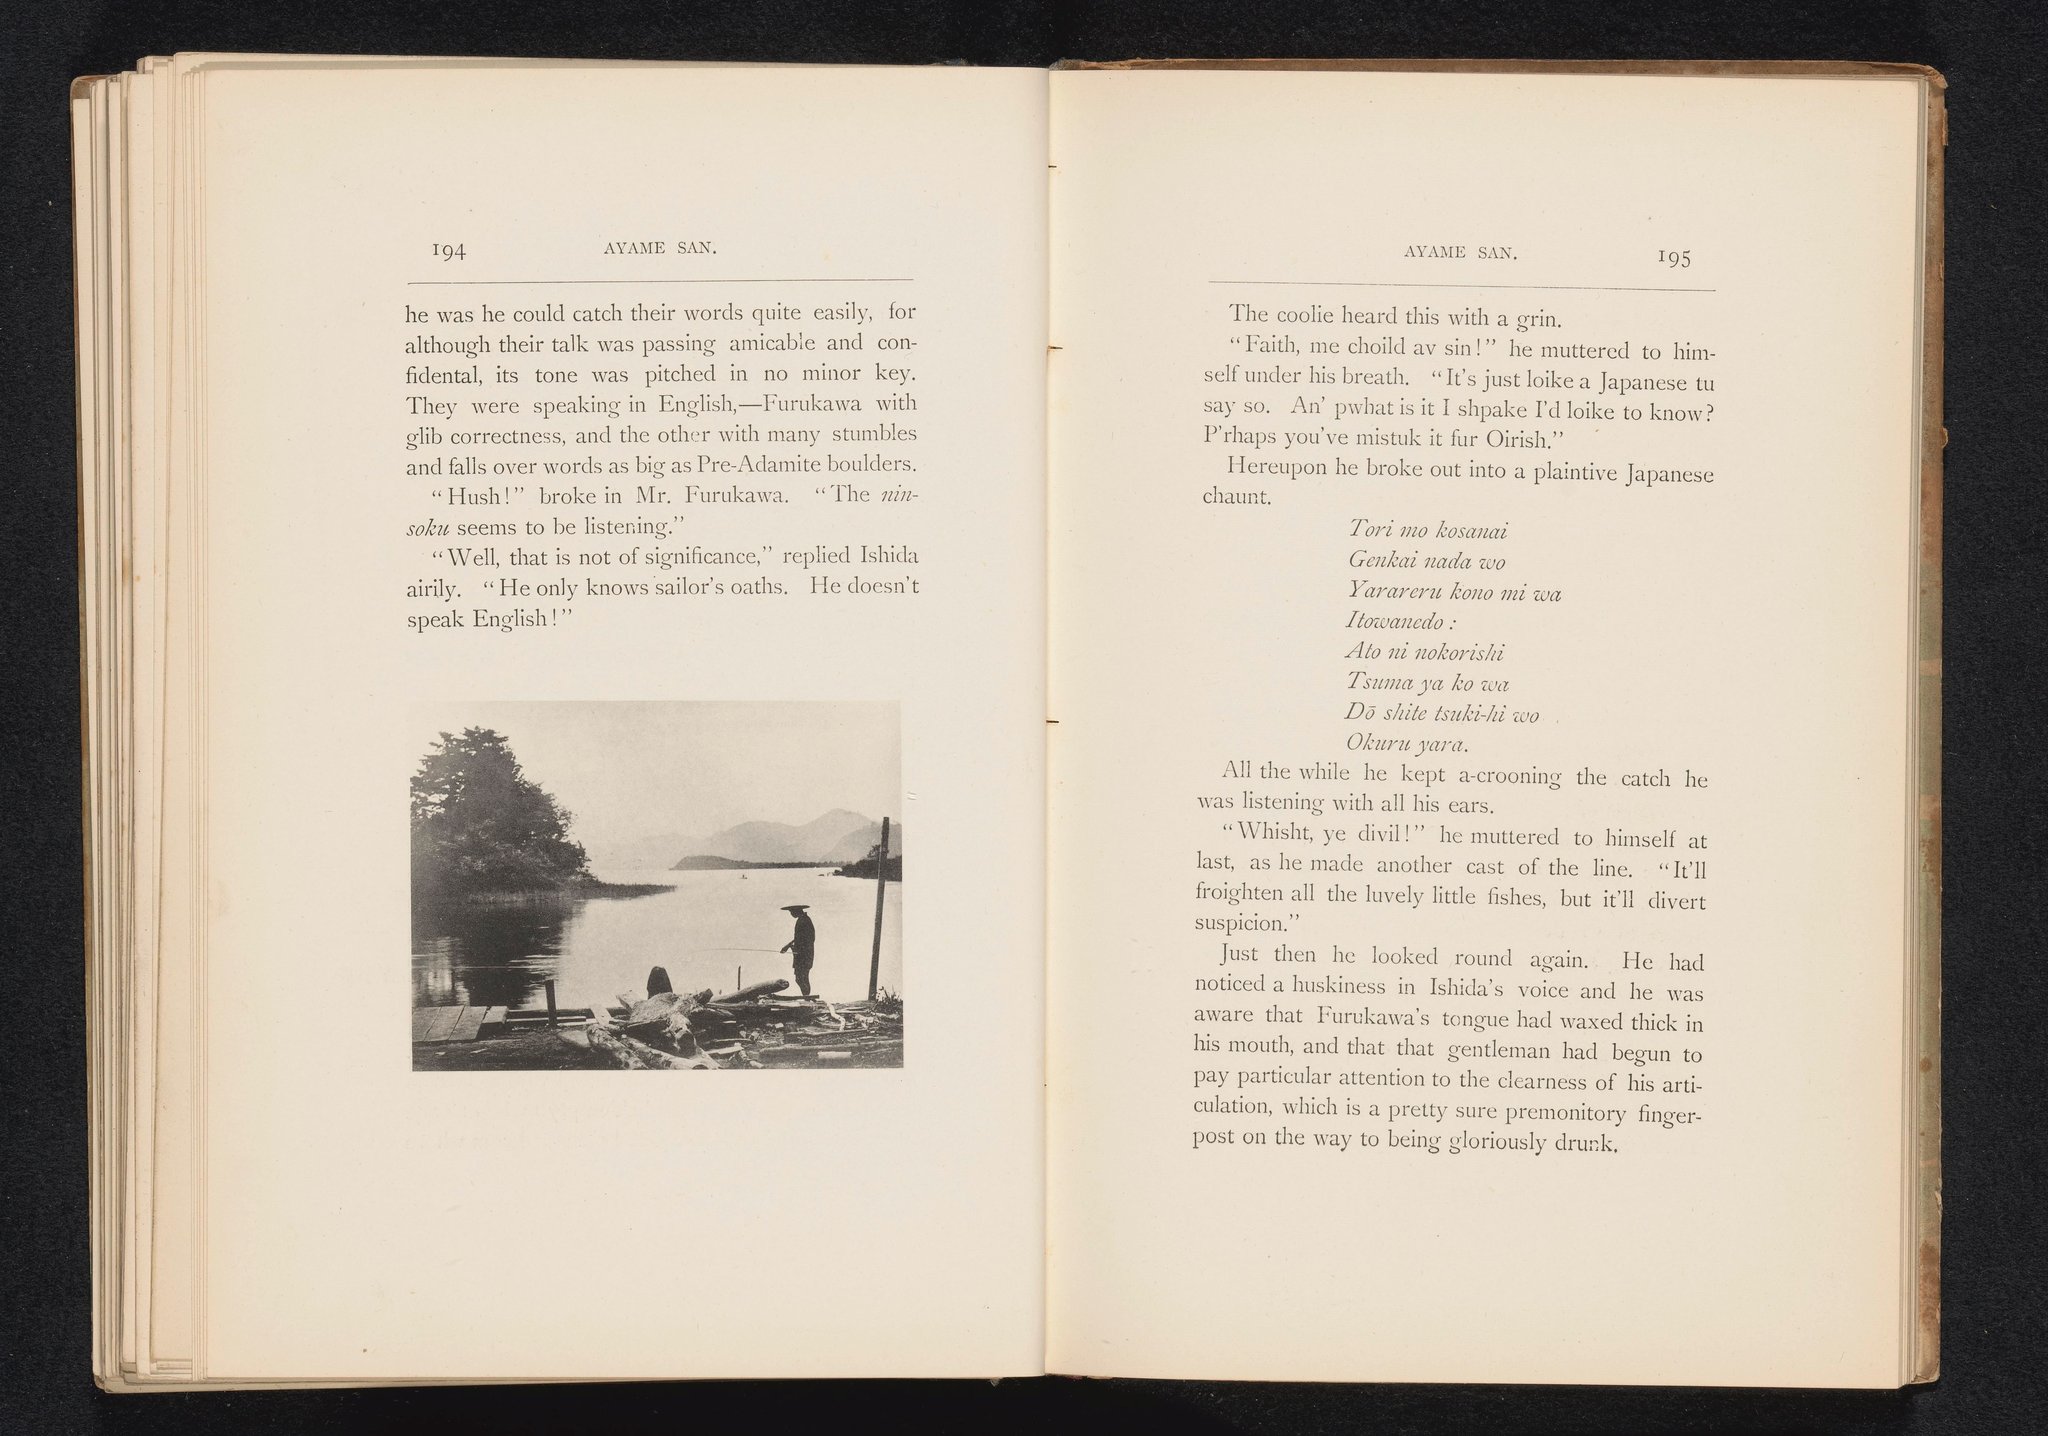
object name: page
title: Gezicht op een meer te Japan, met op de voorgrond een visser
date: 1882-1892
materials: paper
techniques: photograph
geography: japan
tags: lake, fisherman